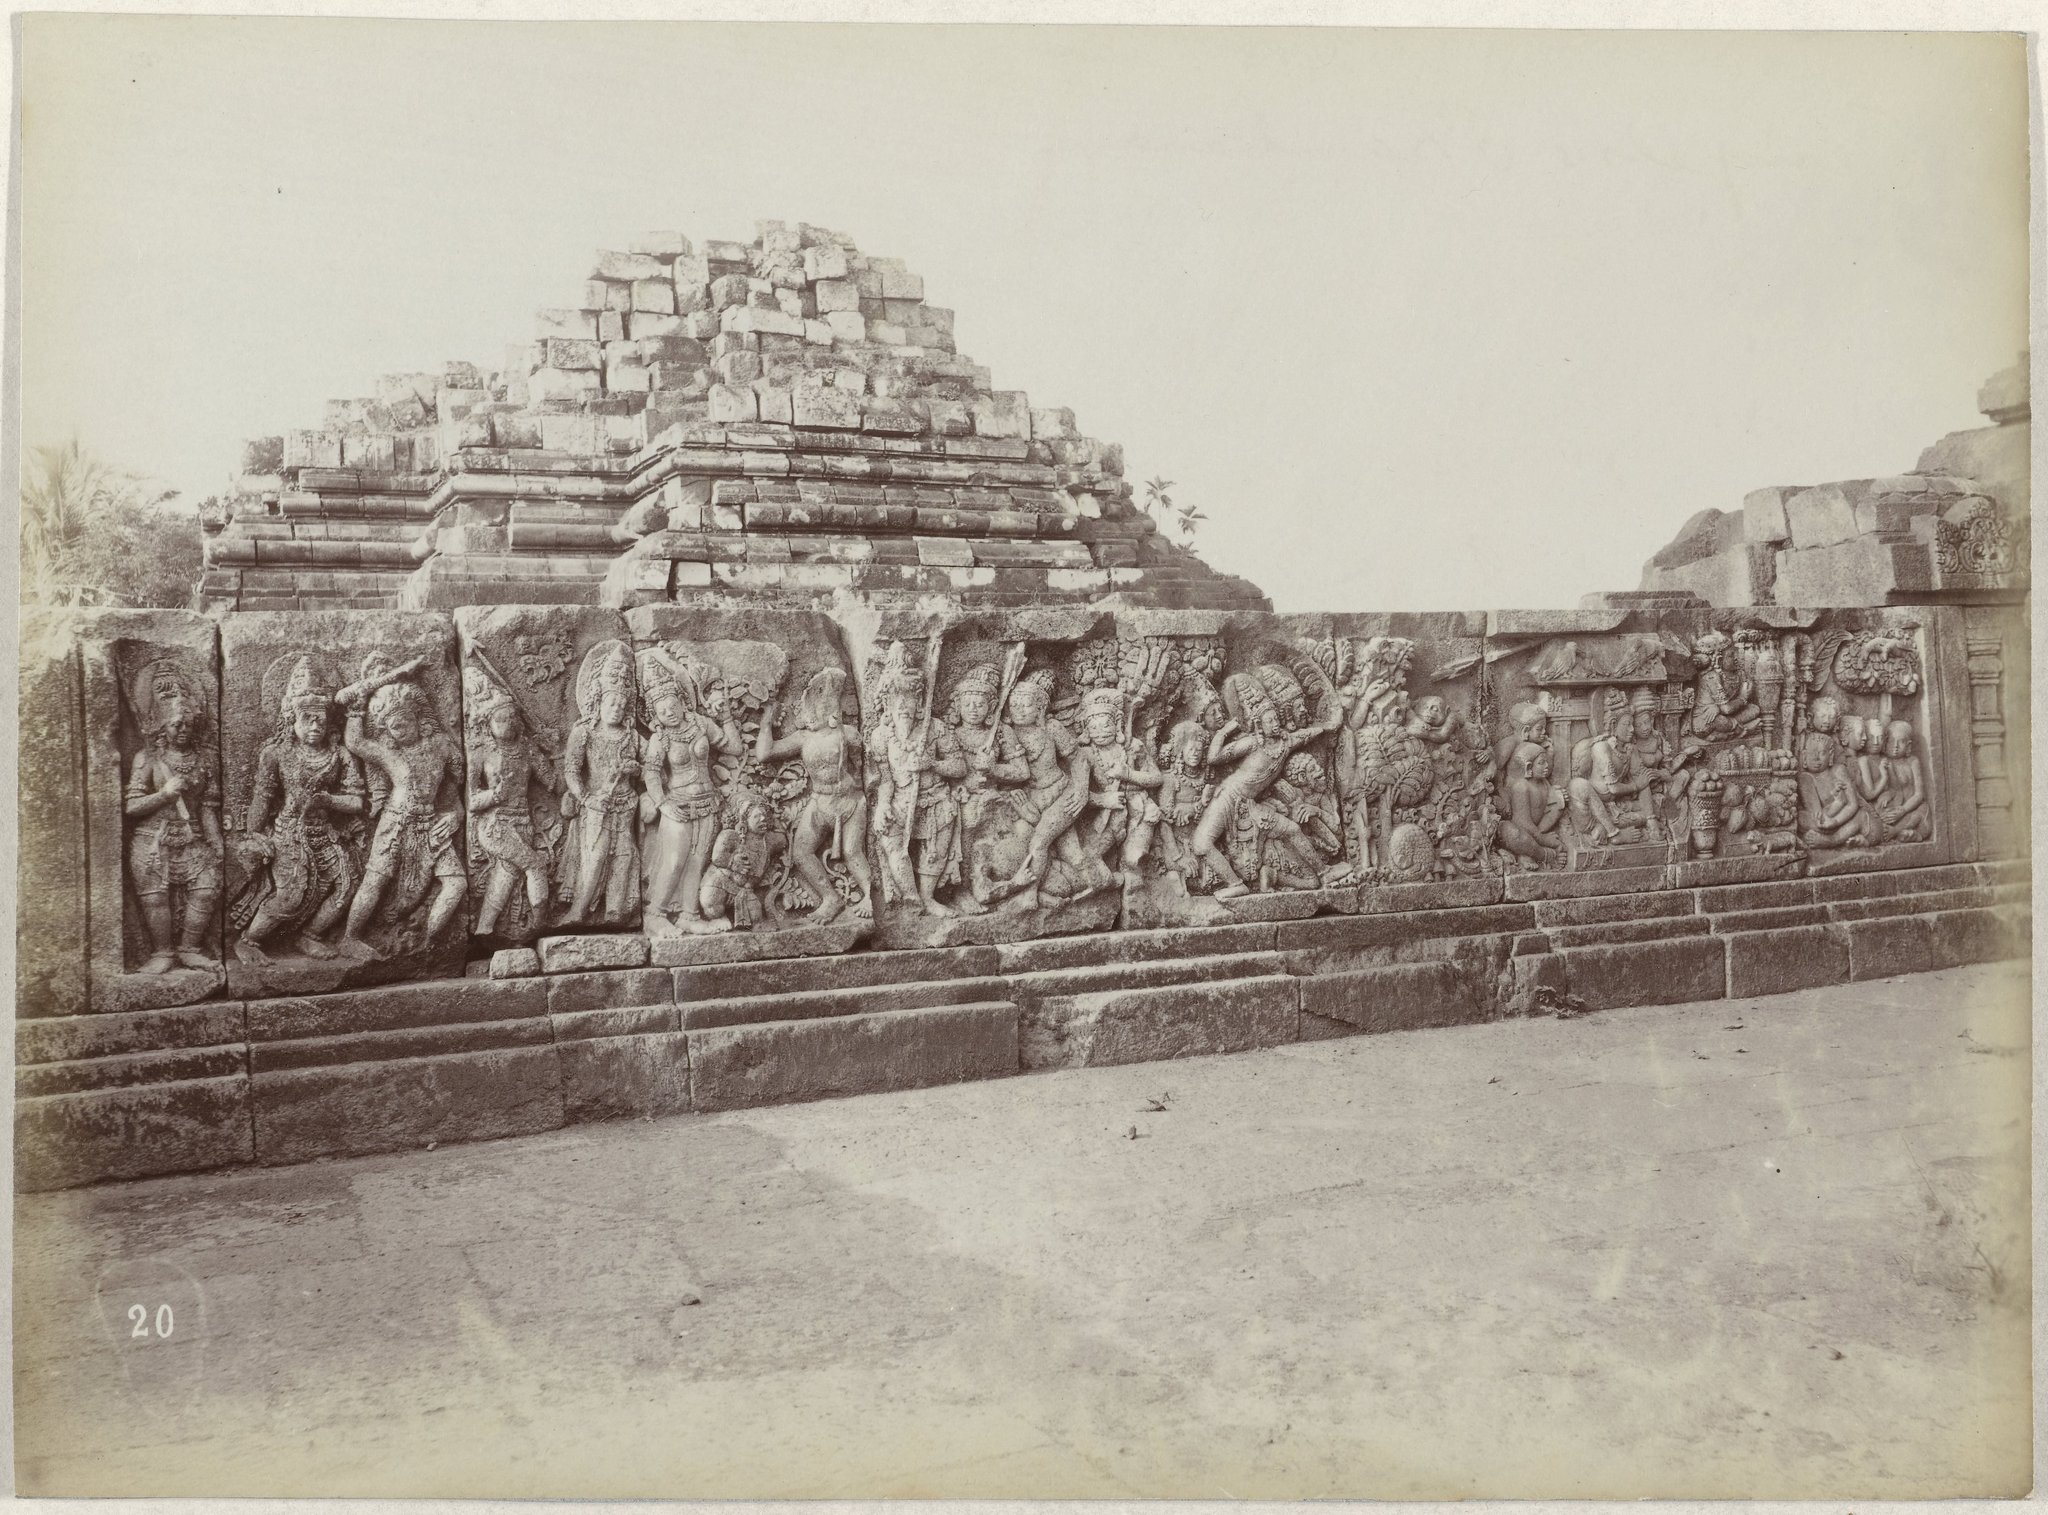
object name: photograph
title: Tempel van Brambanan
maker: onnes kurkdjian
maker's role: fotograaf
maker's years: 1851-1903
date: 1902-1904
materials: paper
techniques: albumen print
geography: prambanan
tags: temple, shrine ~ hinduism, buddhism, jainism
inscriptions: inscription: ‘Tempel van/ Brambanan’, number: ‘20’